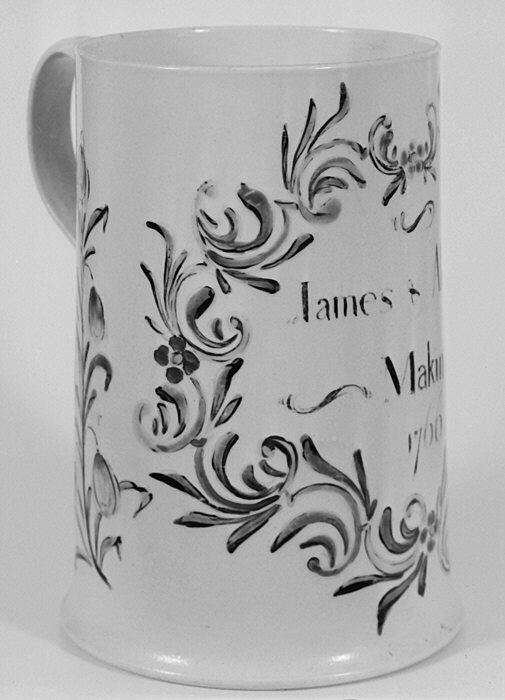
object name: mug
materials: stoneware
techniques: salt glaze